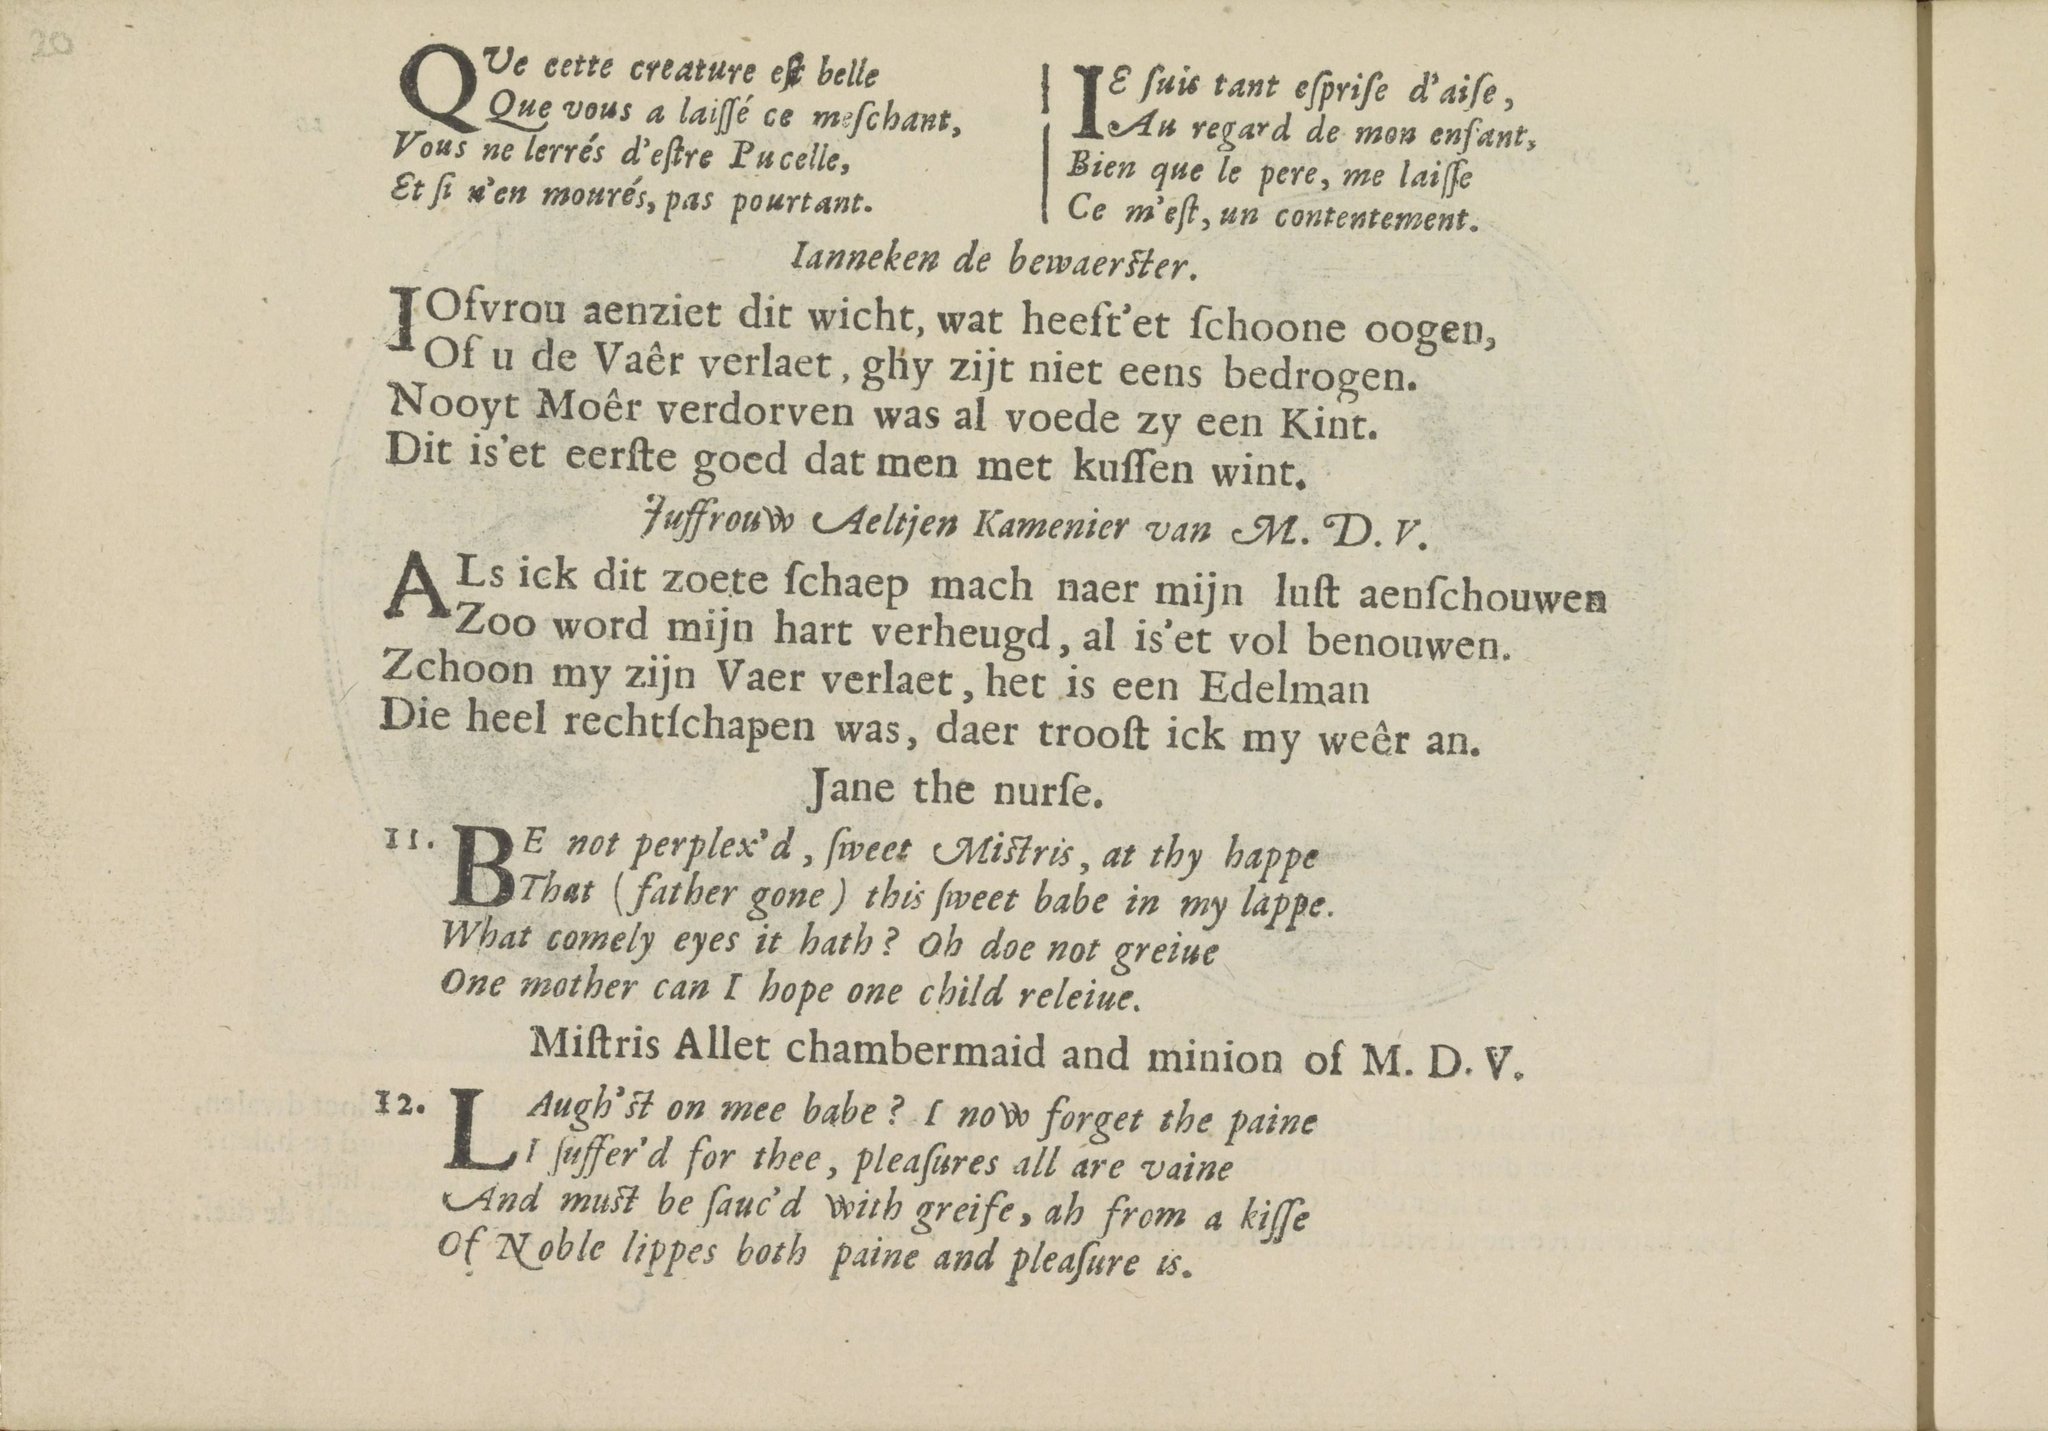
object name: album leaf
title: Kwatrijnen bij voorstellingen van een kamenierster en een baker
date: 1641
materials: paper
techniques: letterpress printing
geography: amsterdam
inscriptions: date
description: Drie keer twee kwatrijnen in het Frans, Nederlands en Engels bij voorstellingen van een kamenierster en een baker. Het blad maakt deel uit van een album.